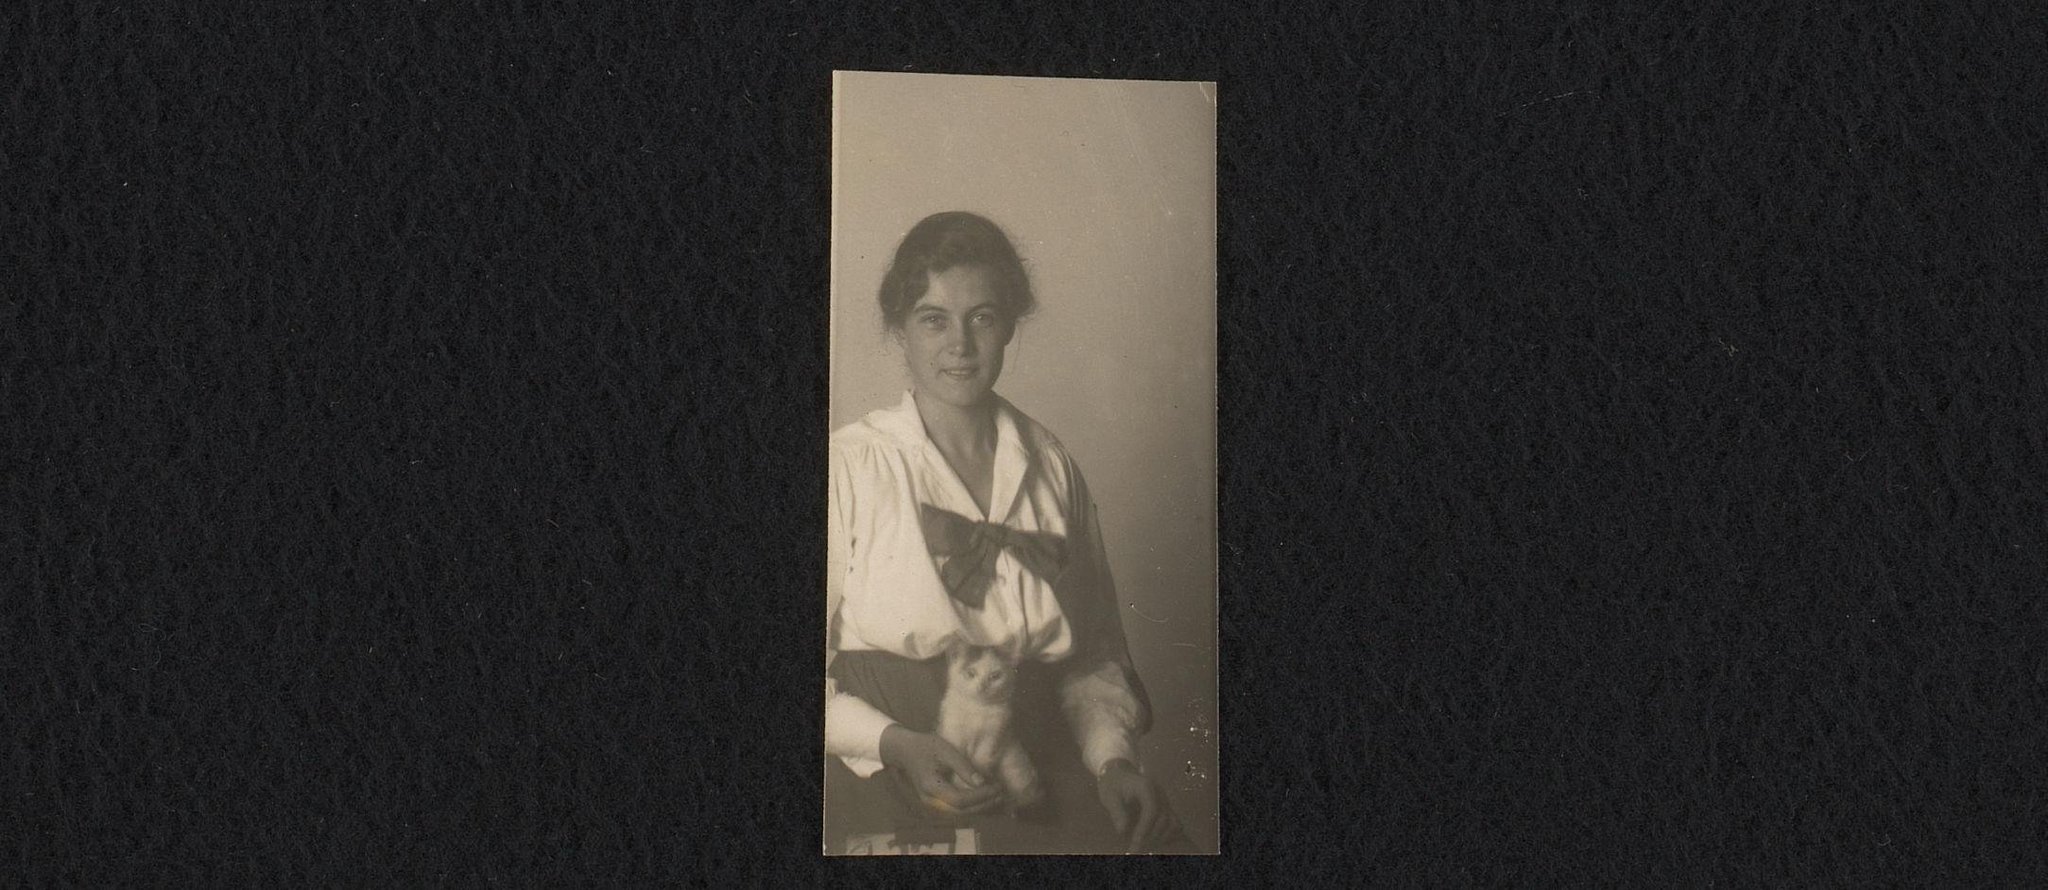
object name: photograph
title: Portret van Johanna (Hans) de Jong met kitten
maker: hendrik waalewijn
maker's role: fotograaf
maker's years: 1890-1964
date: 1915-1920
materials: paper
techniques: gelatin silver print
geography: leiden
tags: johanna petronella lambertina stokhuyzen-de jong (hans), cat, historical persons - bb - woman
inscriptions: address: ‘H. Waalewijn/ Haarl.straat 26/ LEIDEN’